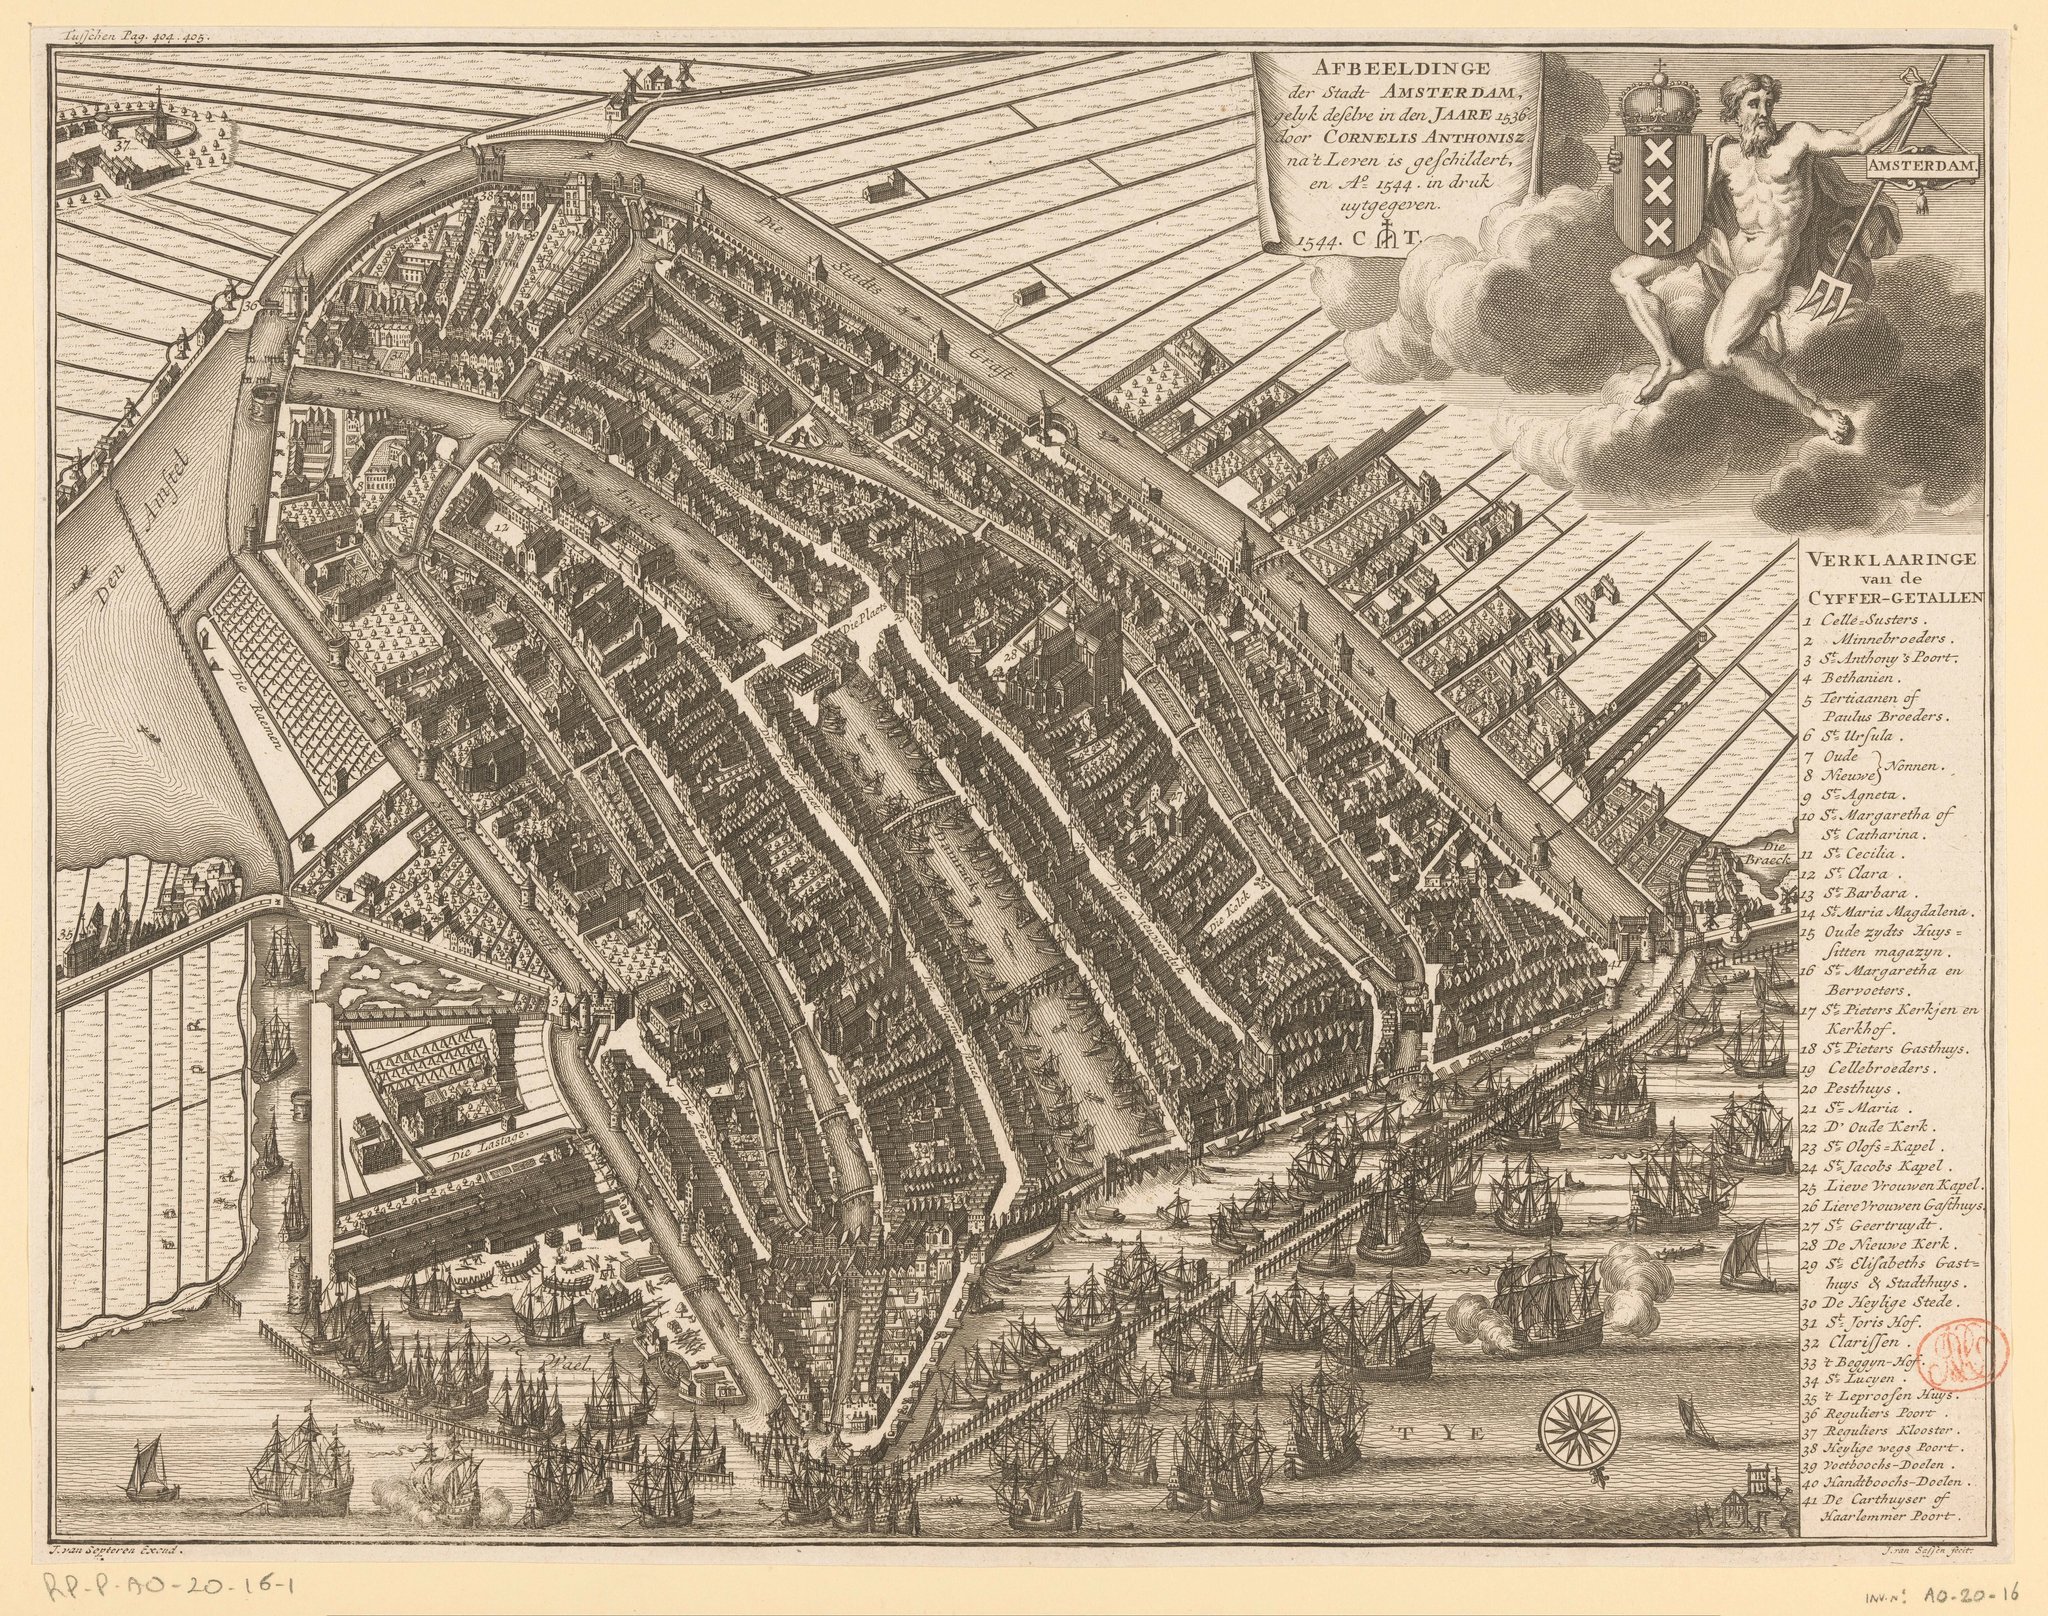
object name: area plan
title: Afbeeldinge der Stadt Amsterdam, gelyk deselve in den Jaare 1536 door Cornelis Anthonisz. na 't Leven is geschildert en Ao. 1544. in druk uytgegeven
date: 1729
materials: paper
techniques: engraving, etching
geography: amsterdam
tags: (story of) neptune (poseidon), coat of arms (as symbol of the state, etc.) (+ city; municipal), maps of cities, amsterdam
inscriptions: collector's mark: Lugt 195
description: Plattegrond in vogelvluchtperspectief. Linksboven gemerkt: Tusschen Pag. 404. 405. Rechtsboven de titelcartouche met rechts daarvan Neptunus op een wolk met het wapen van de stad en zijn drietand. Rechts de legenda 1-41. Oriëntatie: westzuidwest boven.